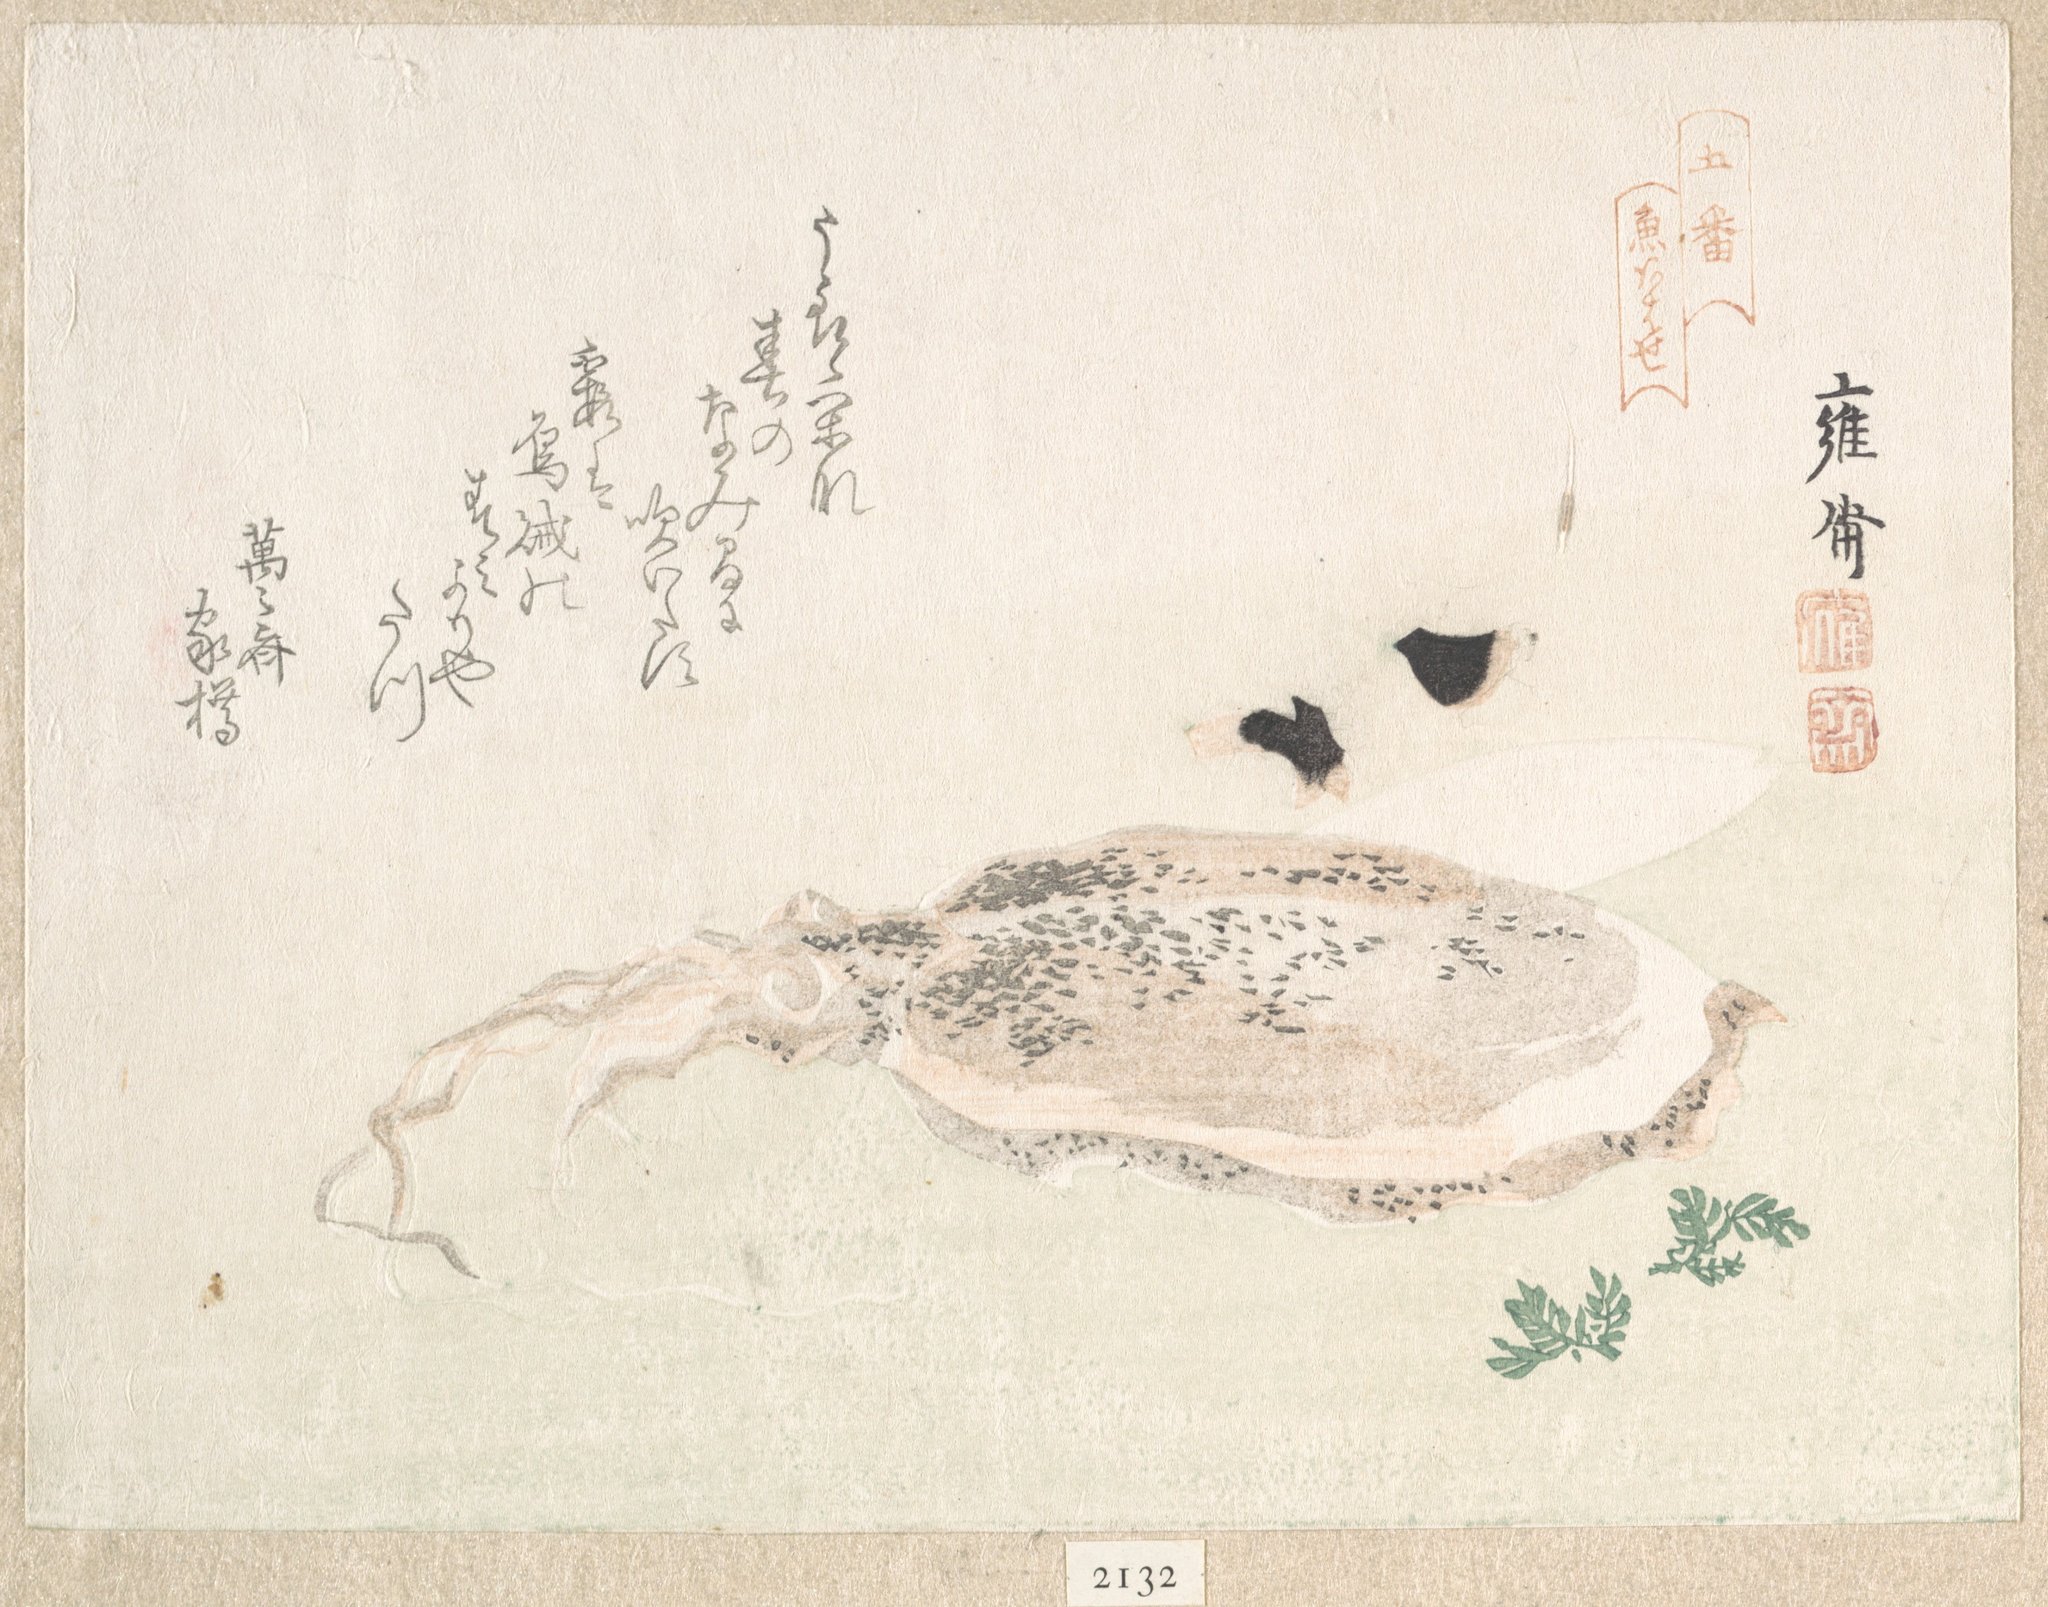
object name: woodblock print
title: Cuttle Fish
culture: japanese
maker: kikuchi yōsai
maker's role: artist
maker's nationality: japanese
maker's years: 1788-1878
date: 1801-1833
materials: ink, paper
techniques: surimono, woodblock print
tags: fish